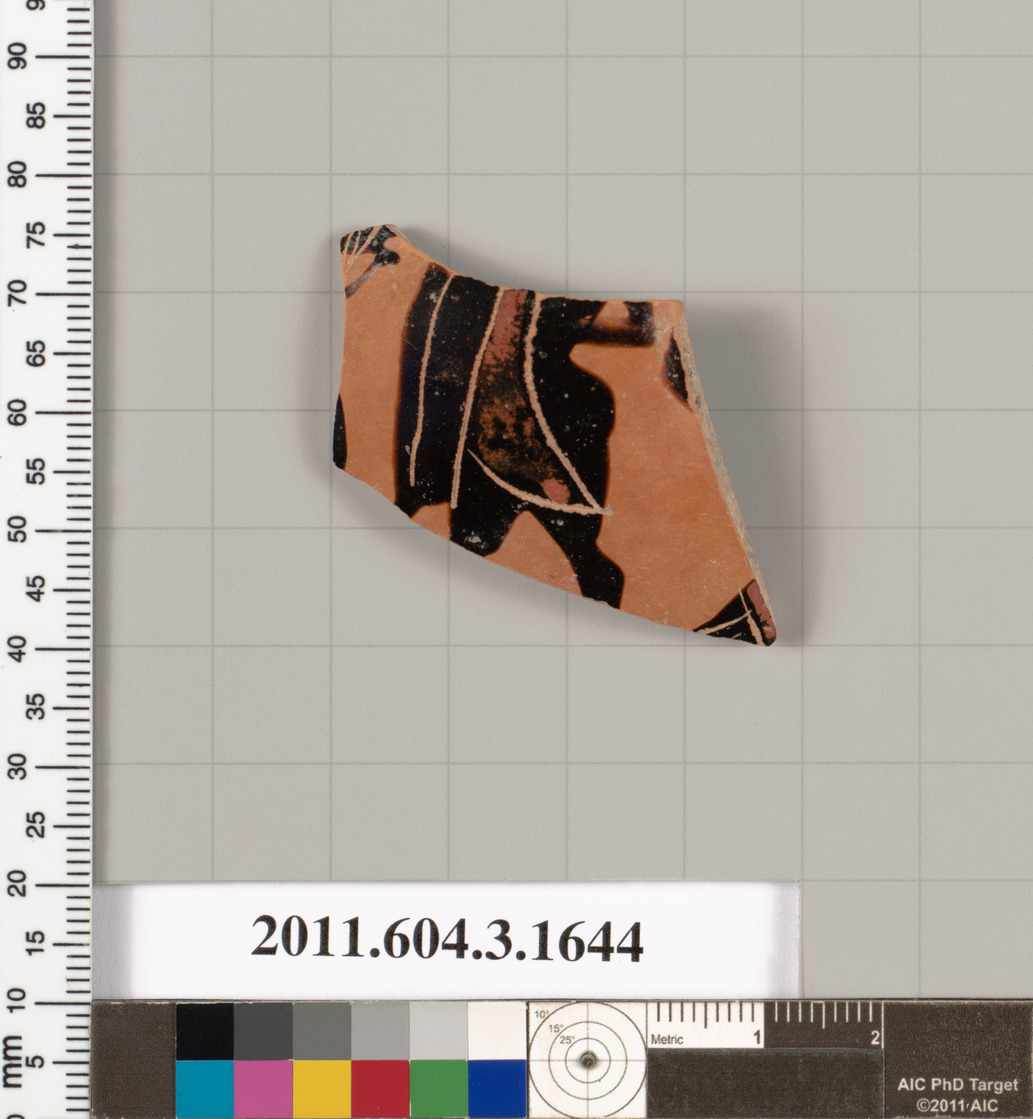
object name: kylix fragment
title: Terracotta fragment of a kylix: Band cup (drinking cup)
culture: greek, attic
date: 525-501 BCE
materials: terracotta